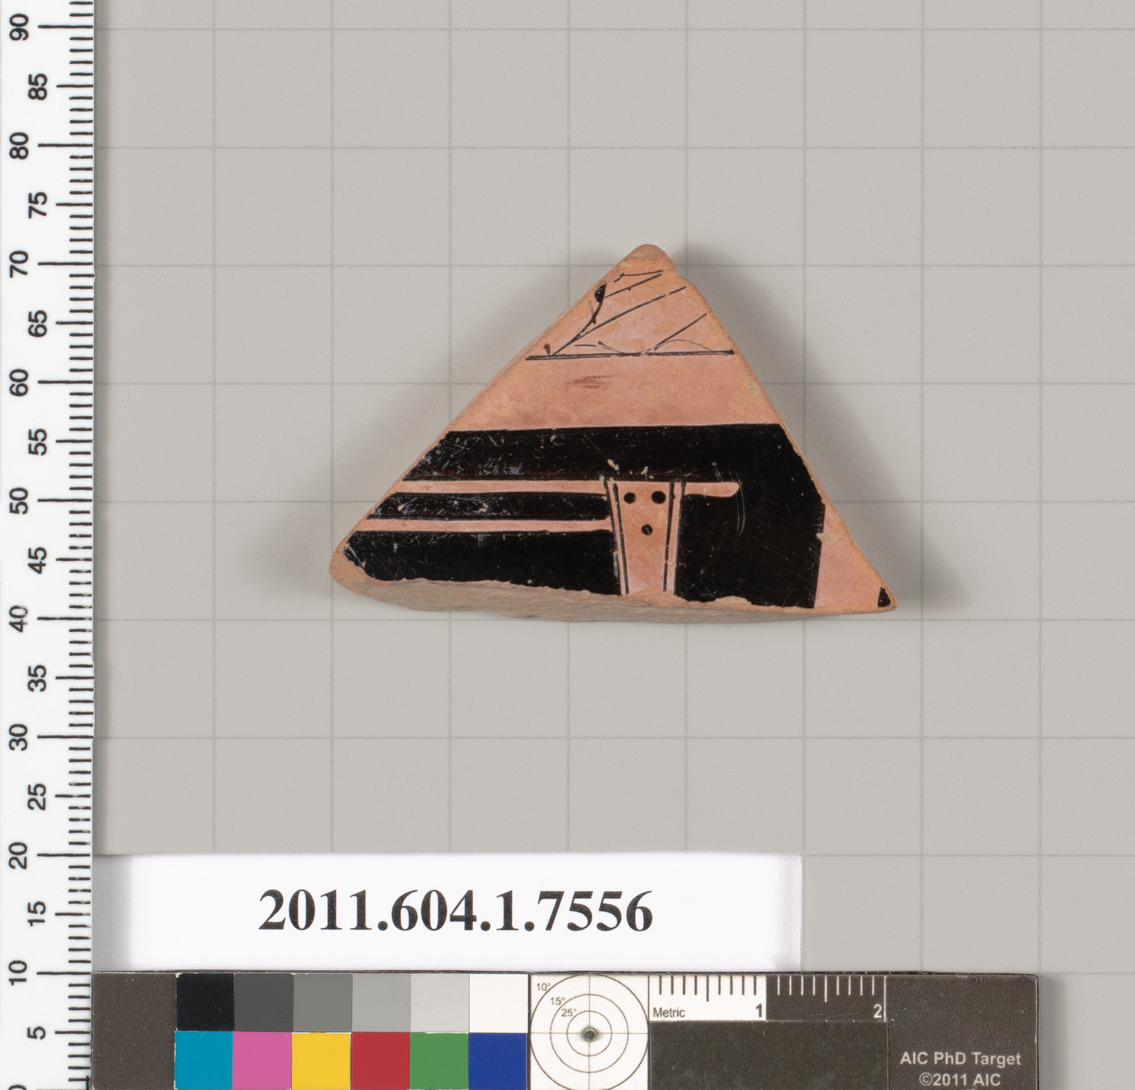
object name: kylix fragment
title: Terracotta fragment of a kylix (drinking cup)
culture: greek, attic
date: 460-450 BCE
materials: terracotta